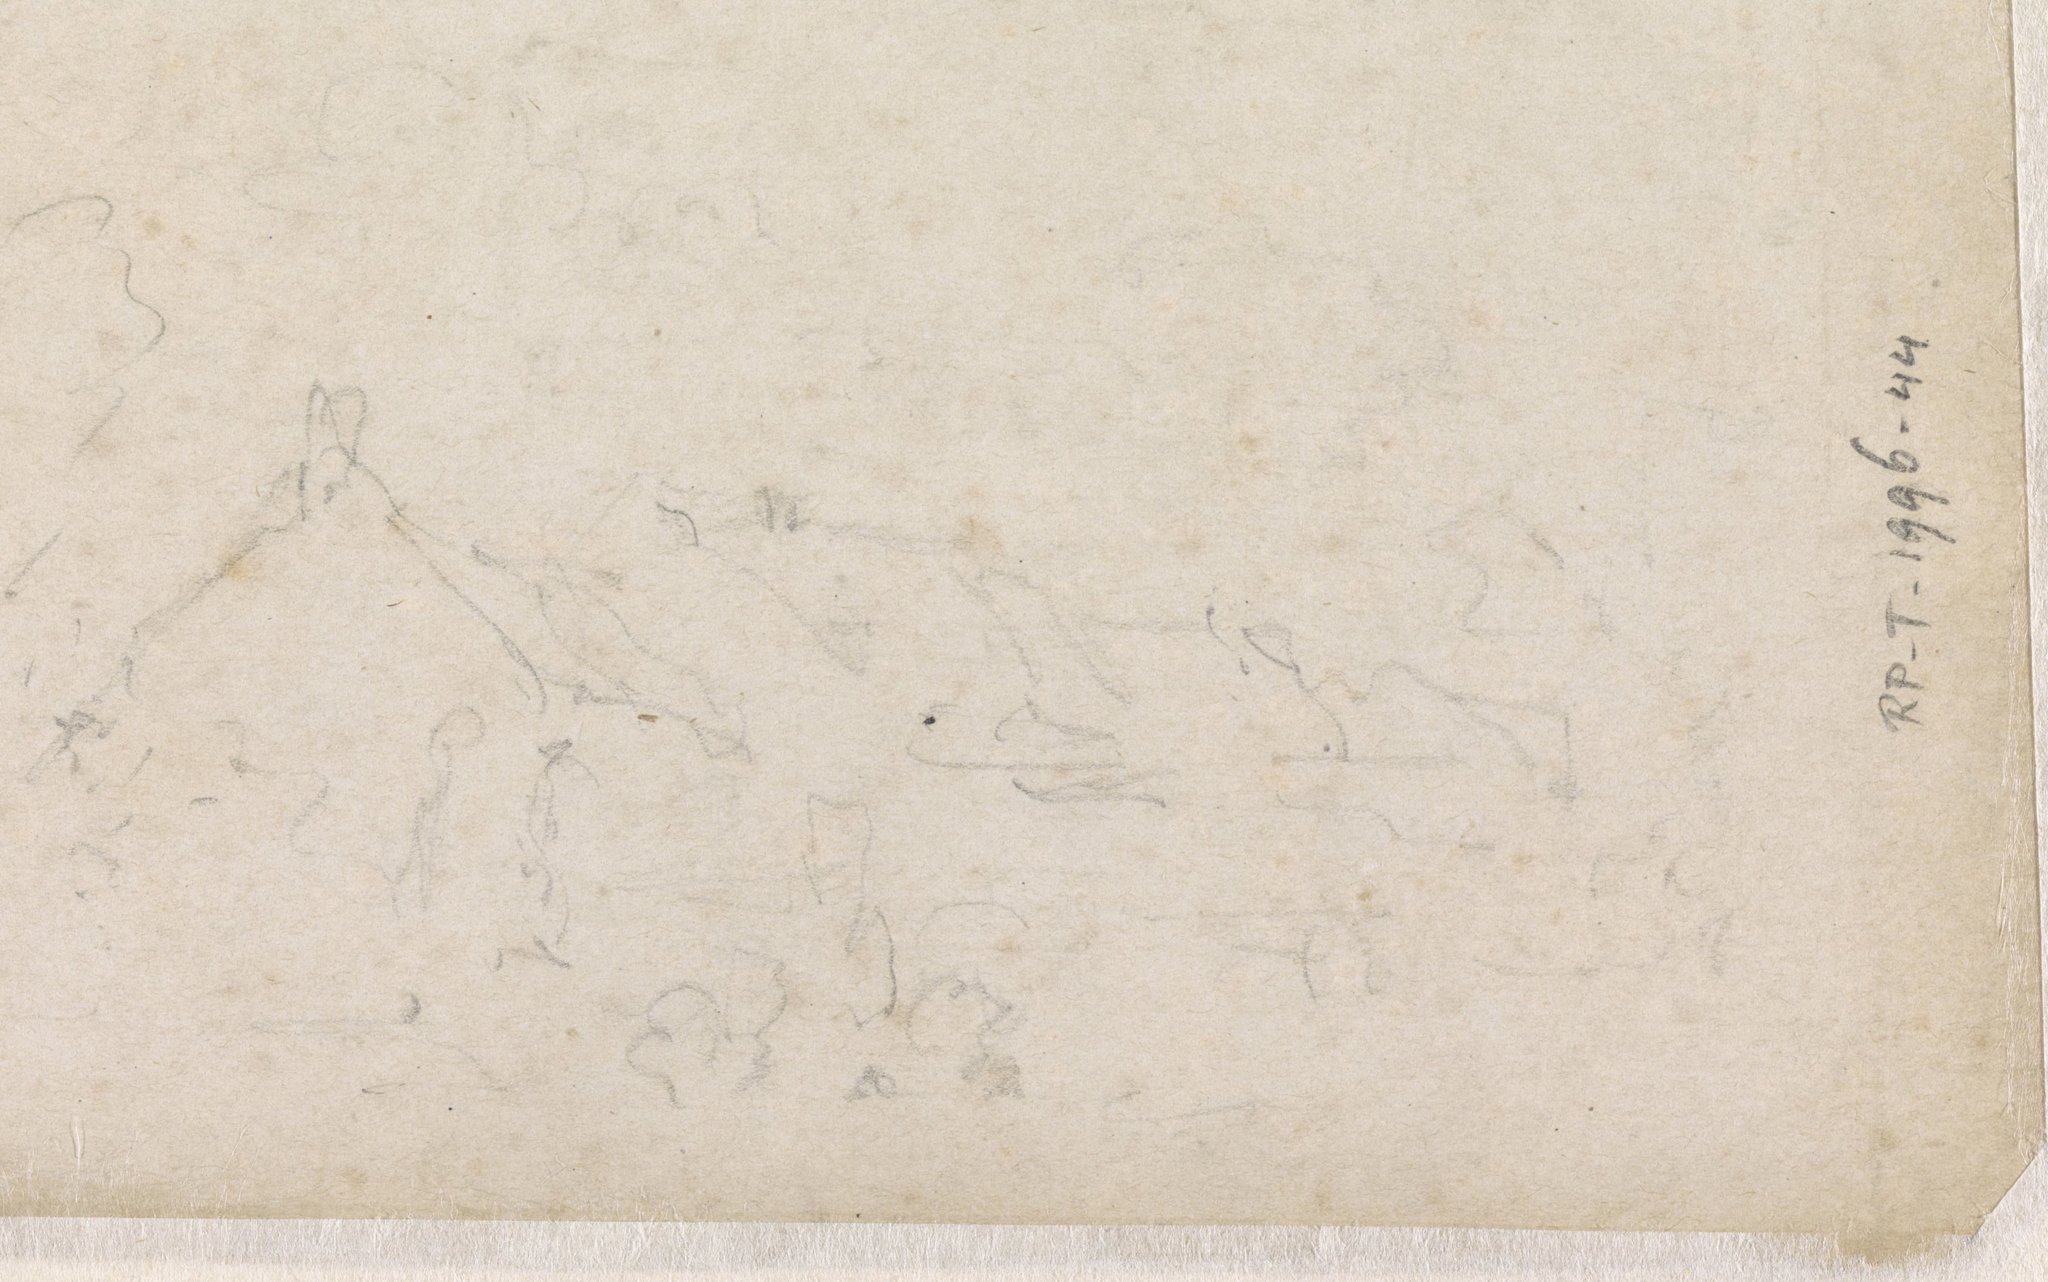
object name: drawing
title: Huizen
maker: adrianus eversen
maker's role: draughtsman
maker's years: 1818-1897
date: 1828-1897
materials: paper, pencil